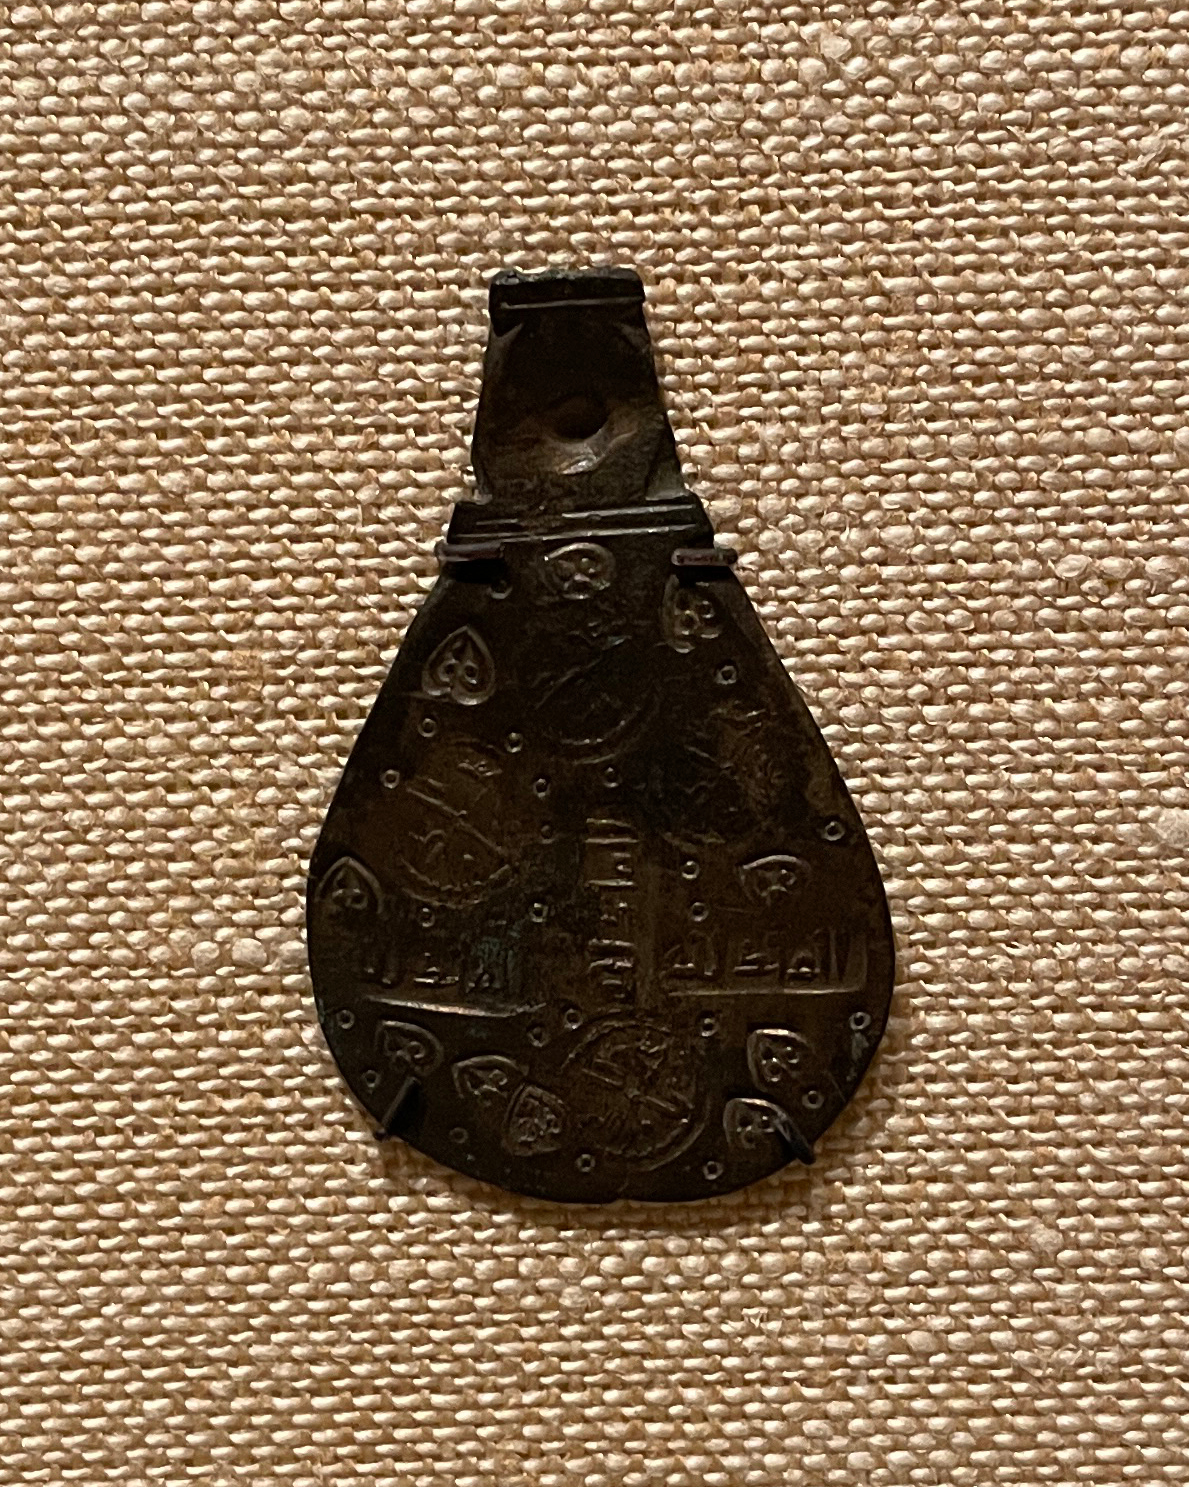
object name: handle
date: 901-1000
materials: bronze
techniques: casting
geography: iran